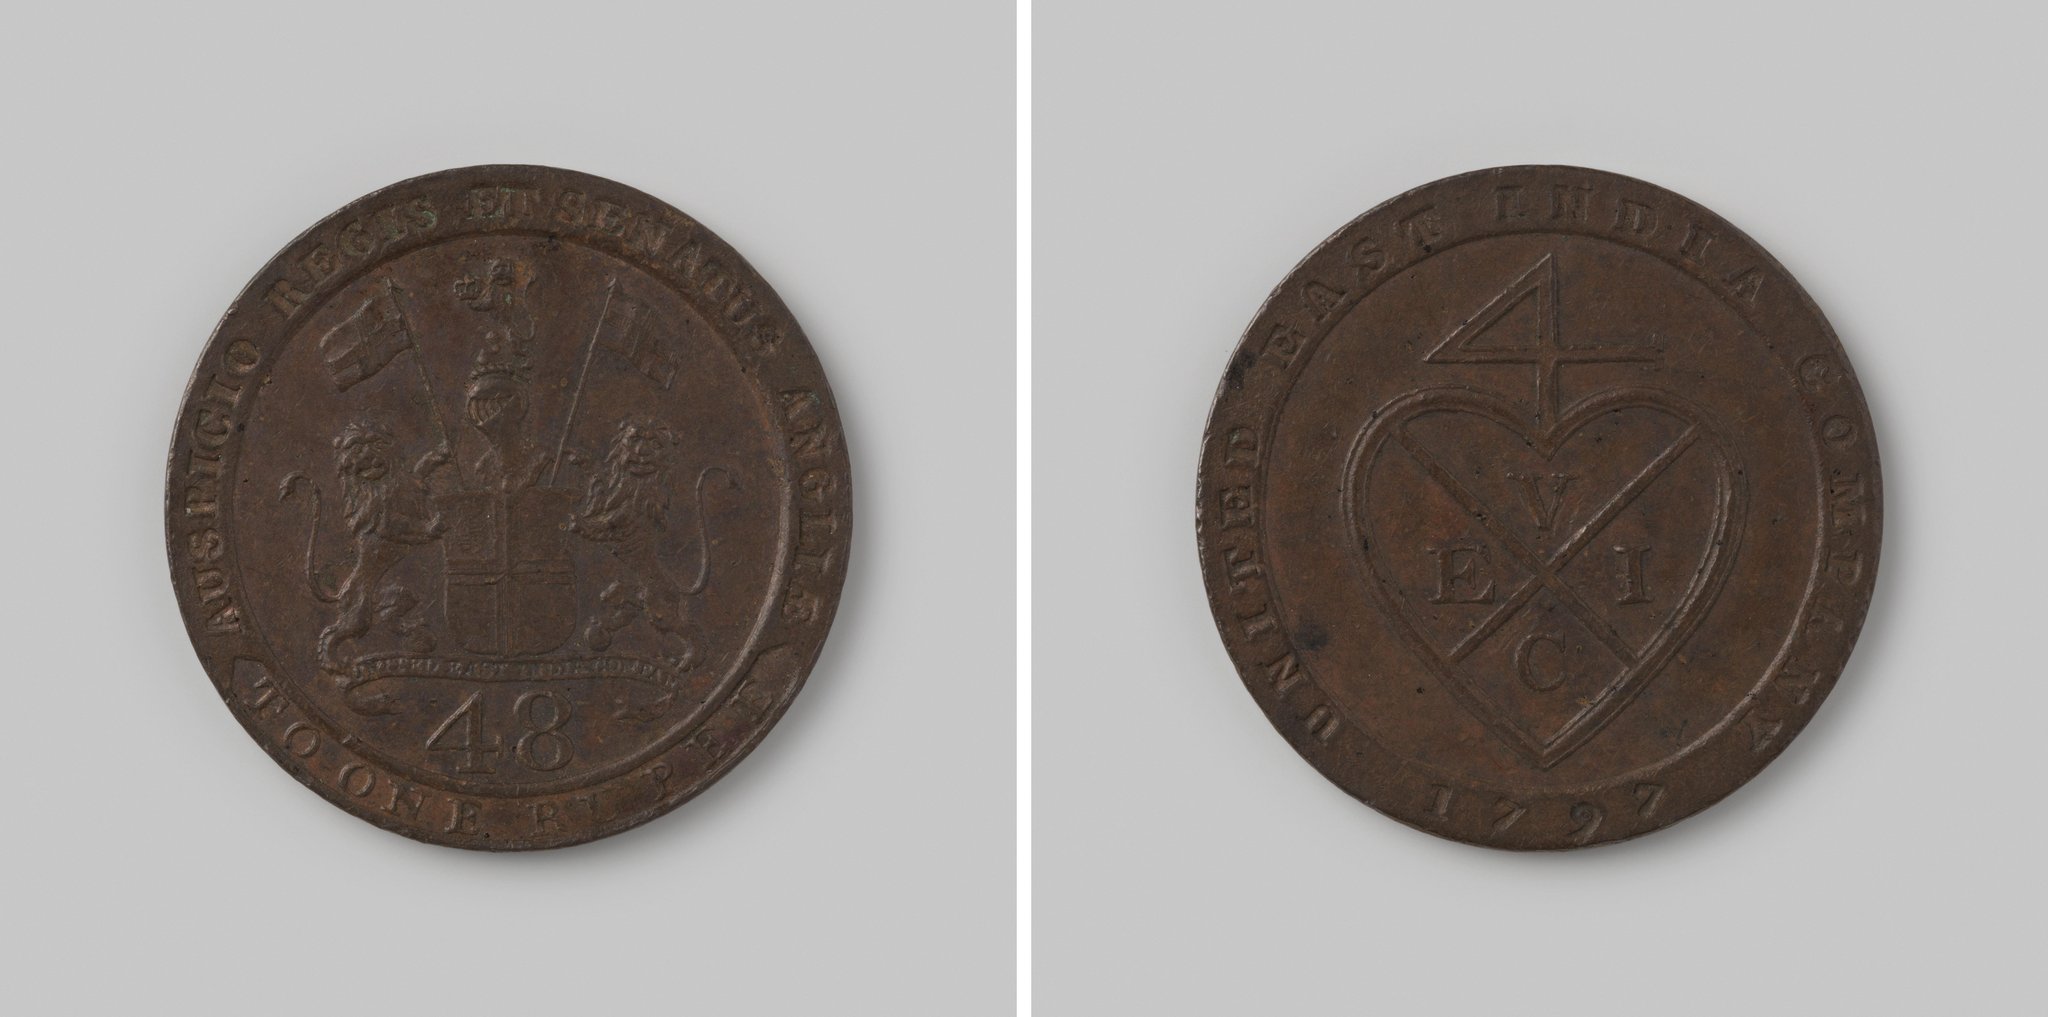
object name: coin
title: Engelse Oostindische Compagnie (EIC), Northern Circars, Madras, India, 1/48 roepie,1797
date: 1797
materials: copper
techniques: striking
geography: birmingham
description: Koperen munt. Voorzijde: door twee op banderol, waarin opschrift, staande leeuwen met pijl, waaraan vlag, in de klauw, gehouden wapenschild van de EIC, waarboven helmteken. Daaronder in twee regels waarde-aanduiding: 48 to one rupee. Keerzijde: monogram van de EIC. Jaartal onderaan in omschrift. Randschrift.